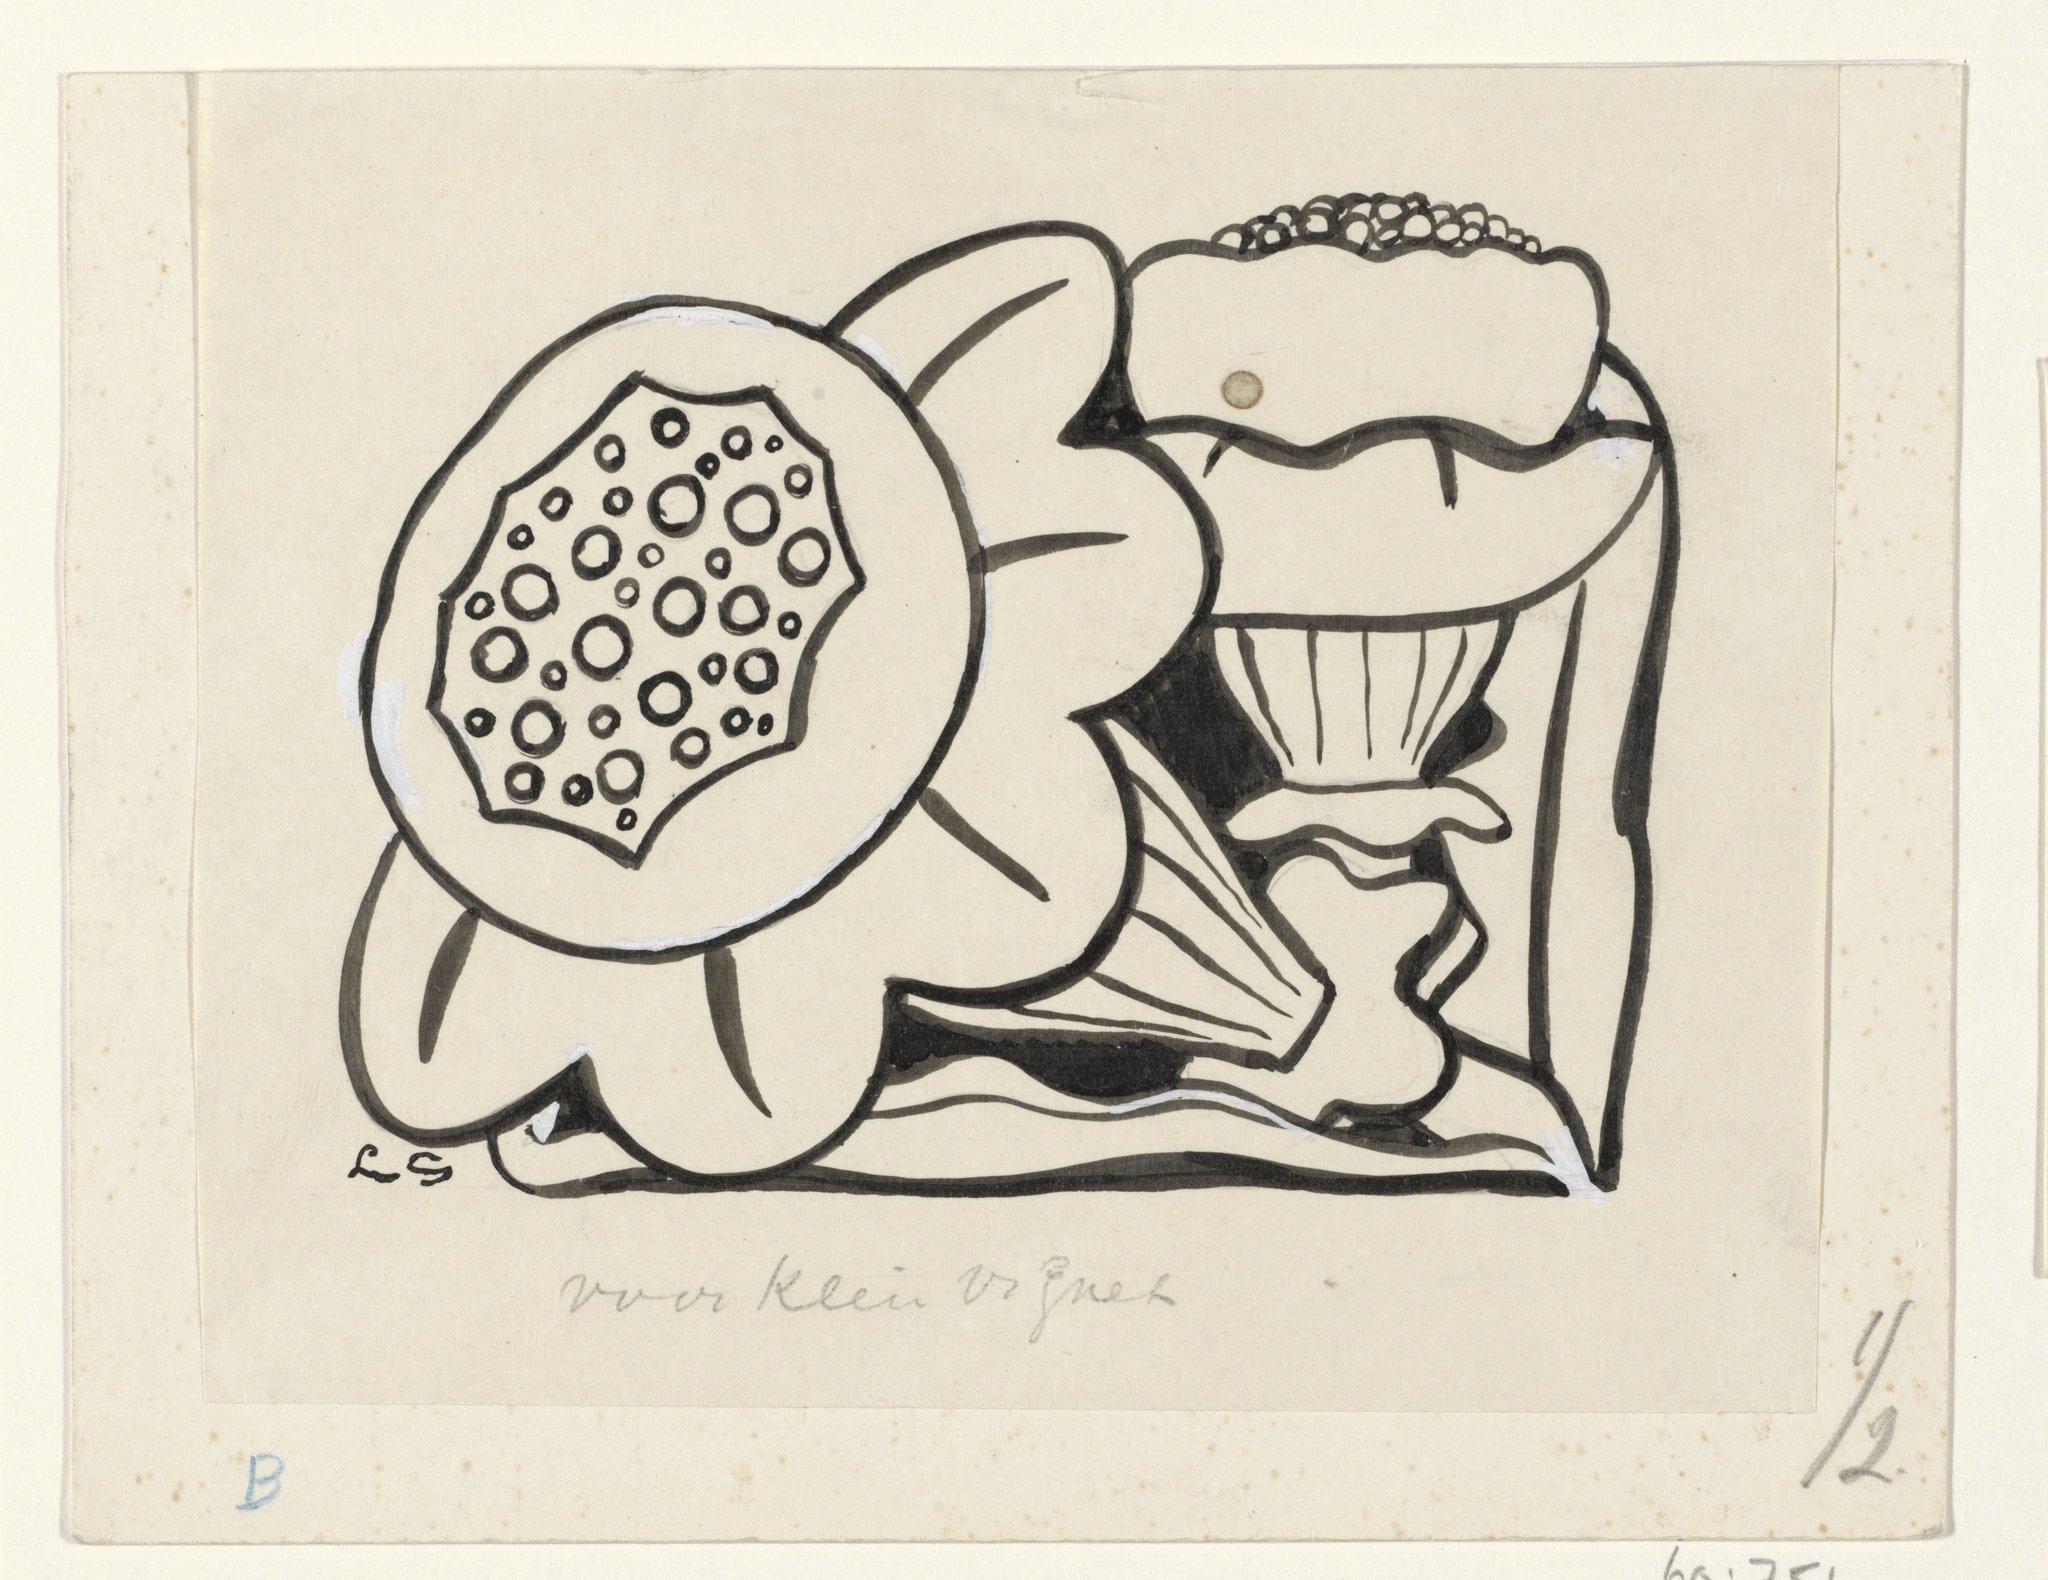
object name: design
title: Twee bloemen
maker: leo gestel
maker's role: draughtsman, print maker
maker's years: 1881-1941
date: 1891-1941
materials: paint, ink, paper, pencil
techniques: brush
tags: flowers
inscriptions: :, collector's mark: Lugt 2228